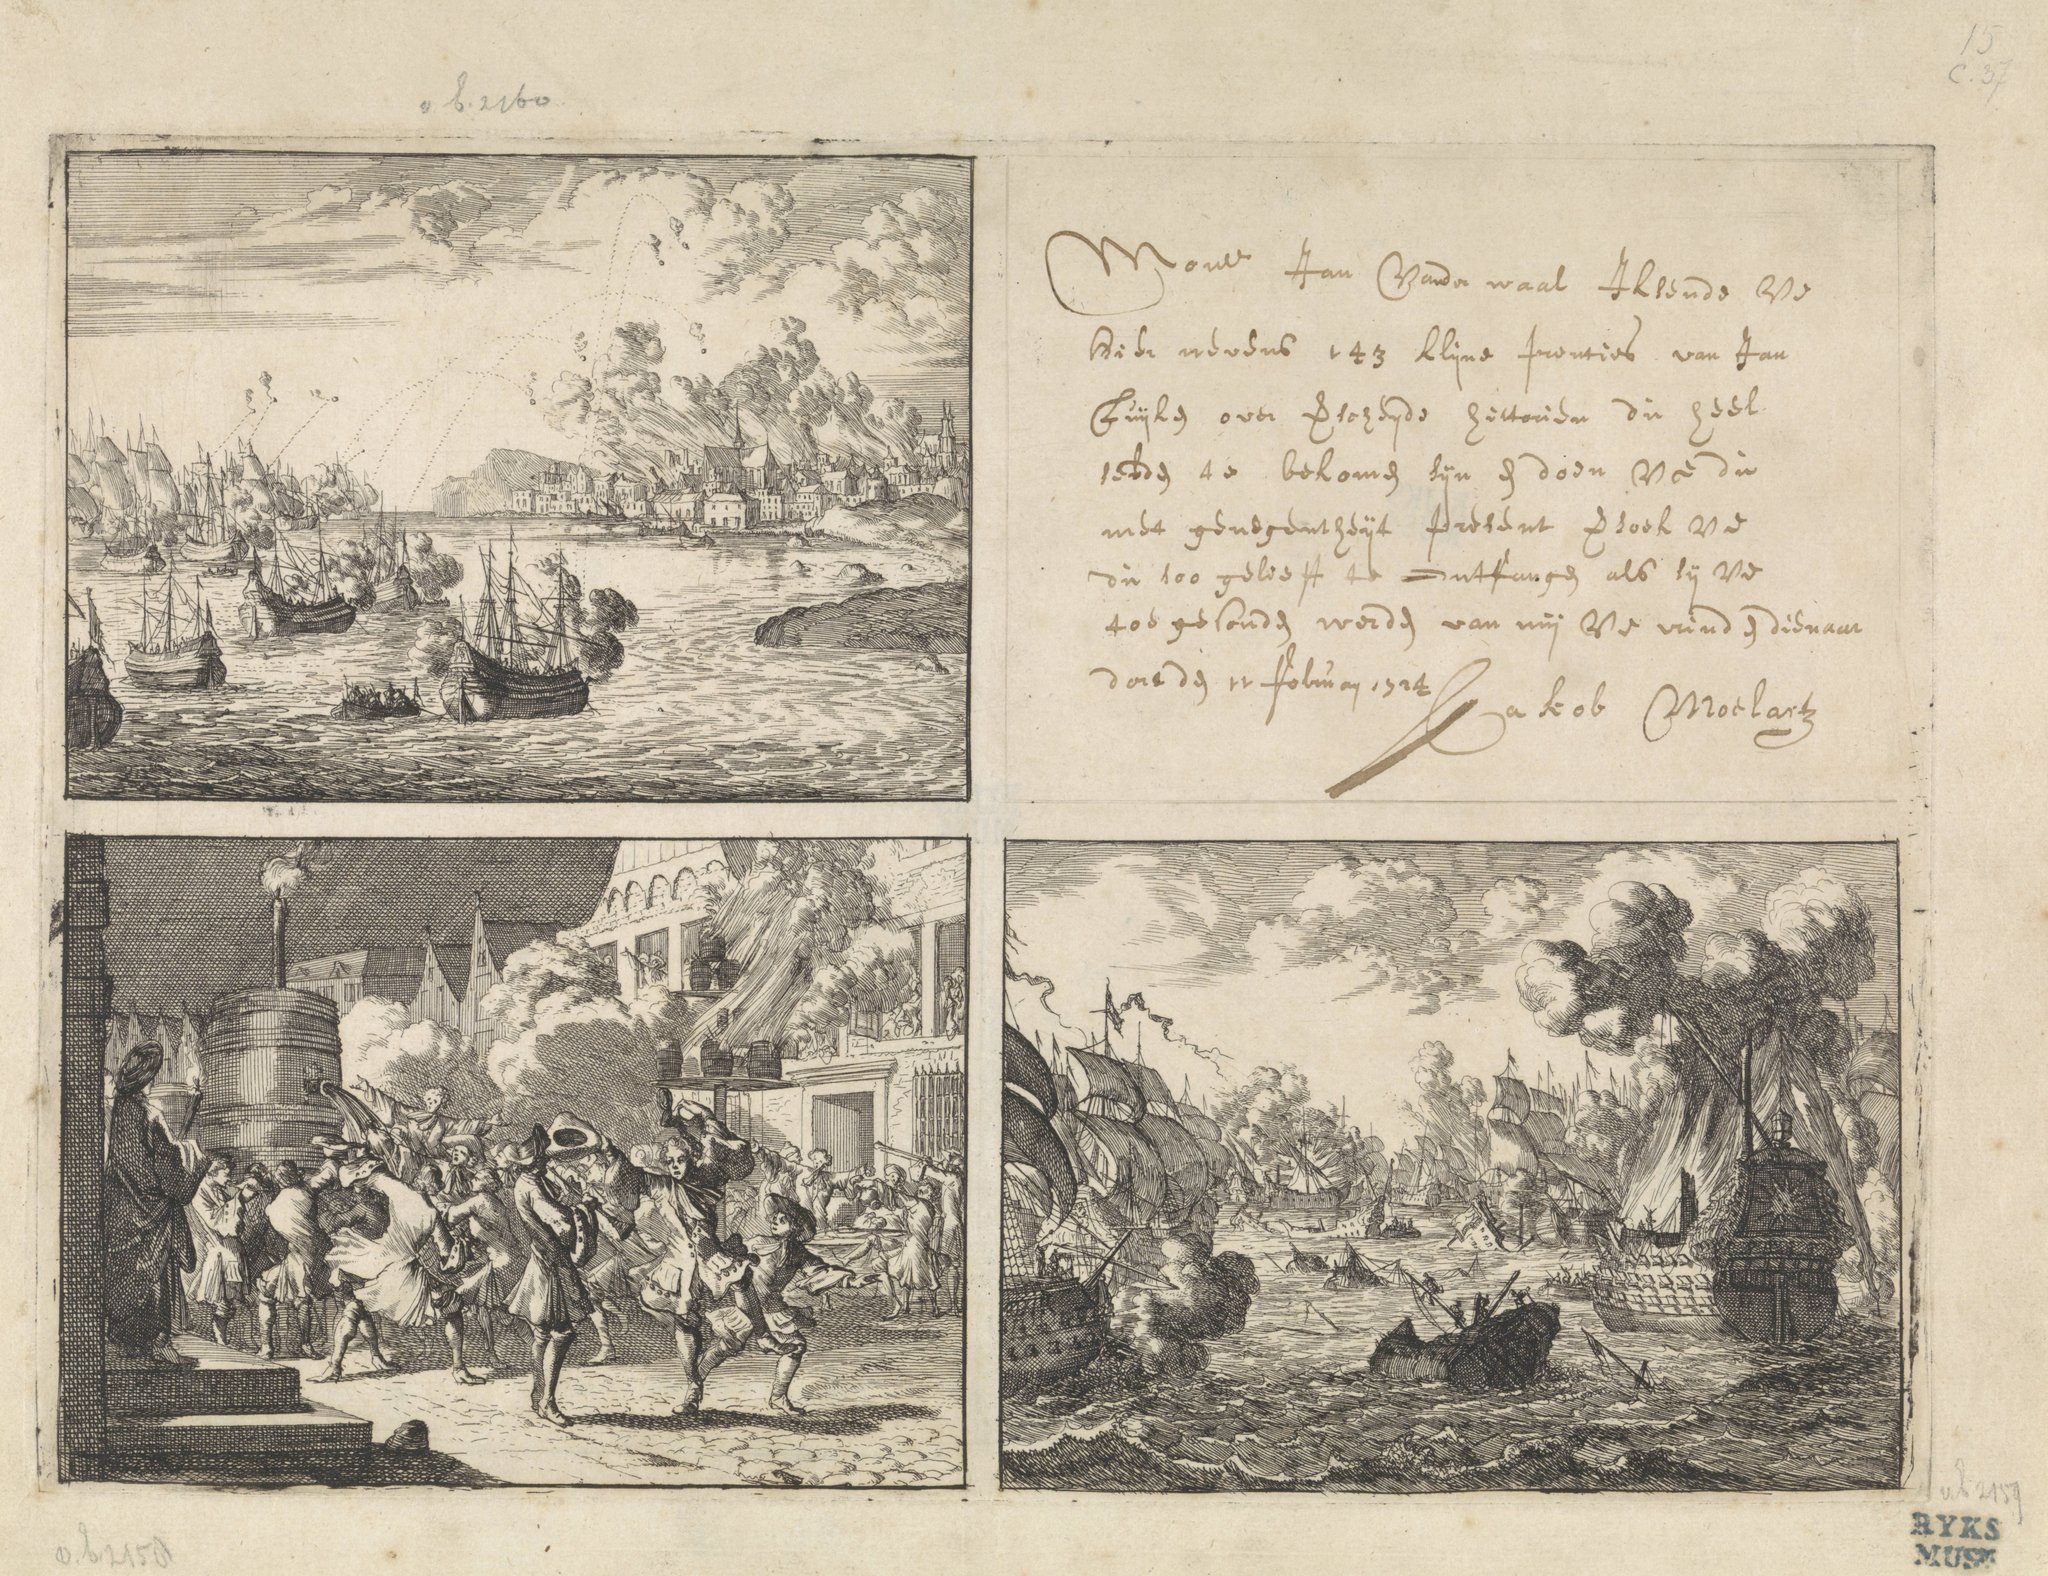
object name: print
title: Bombardement van Dieppe, 1694 / Zeeslag bij Kaap La Hogue, 1692 / Vreugde in Parijs naar aanleiding van het valse bericht van de dood van Willem III bij de slag aan de Boyne, 1690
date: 1698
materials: paper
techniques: etching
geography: amsterdam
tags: the hague, william iii (prince of orange and king of england, scotland, and ireland), paris, battle (+ naval force), public festivities, maps of cities, bombardment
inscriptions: inscription: ‘Monsr. Jan [...] Jakob Moelart’, collector's mark: Lugt 2166, collector's mark: Lugt 2165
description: Prenten gebruikt als illustratie in: Gottfried, Johann Ludwig. Historische kronyck; vervattende een (...) beschrijvingh der aldergedenckwaerdigste geschiedenissen des weerelds, van den aenvangh der scheppingh tot (...) 1576 (2 delen). Leiden: Pieter van der Aa, 1698, dl. II, p. 1457, 1449, 1439.